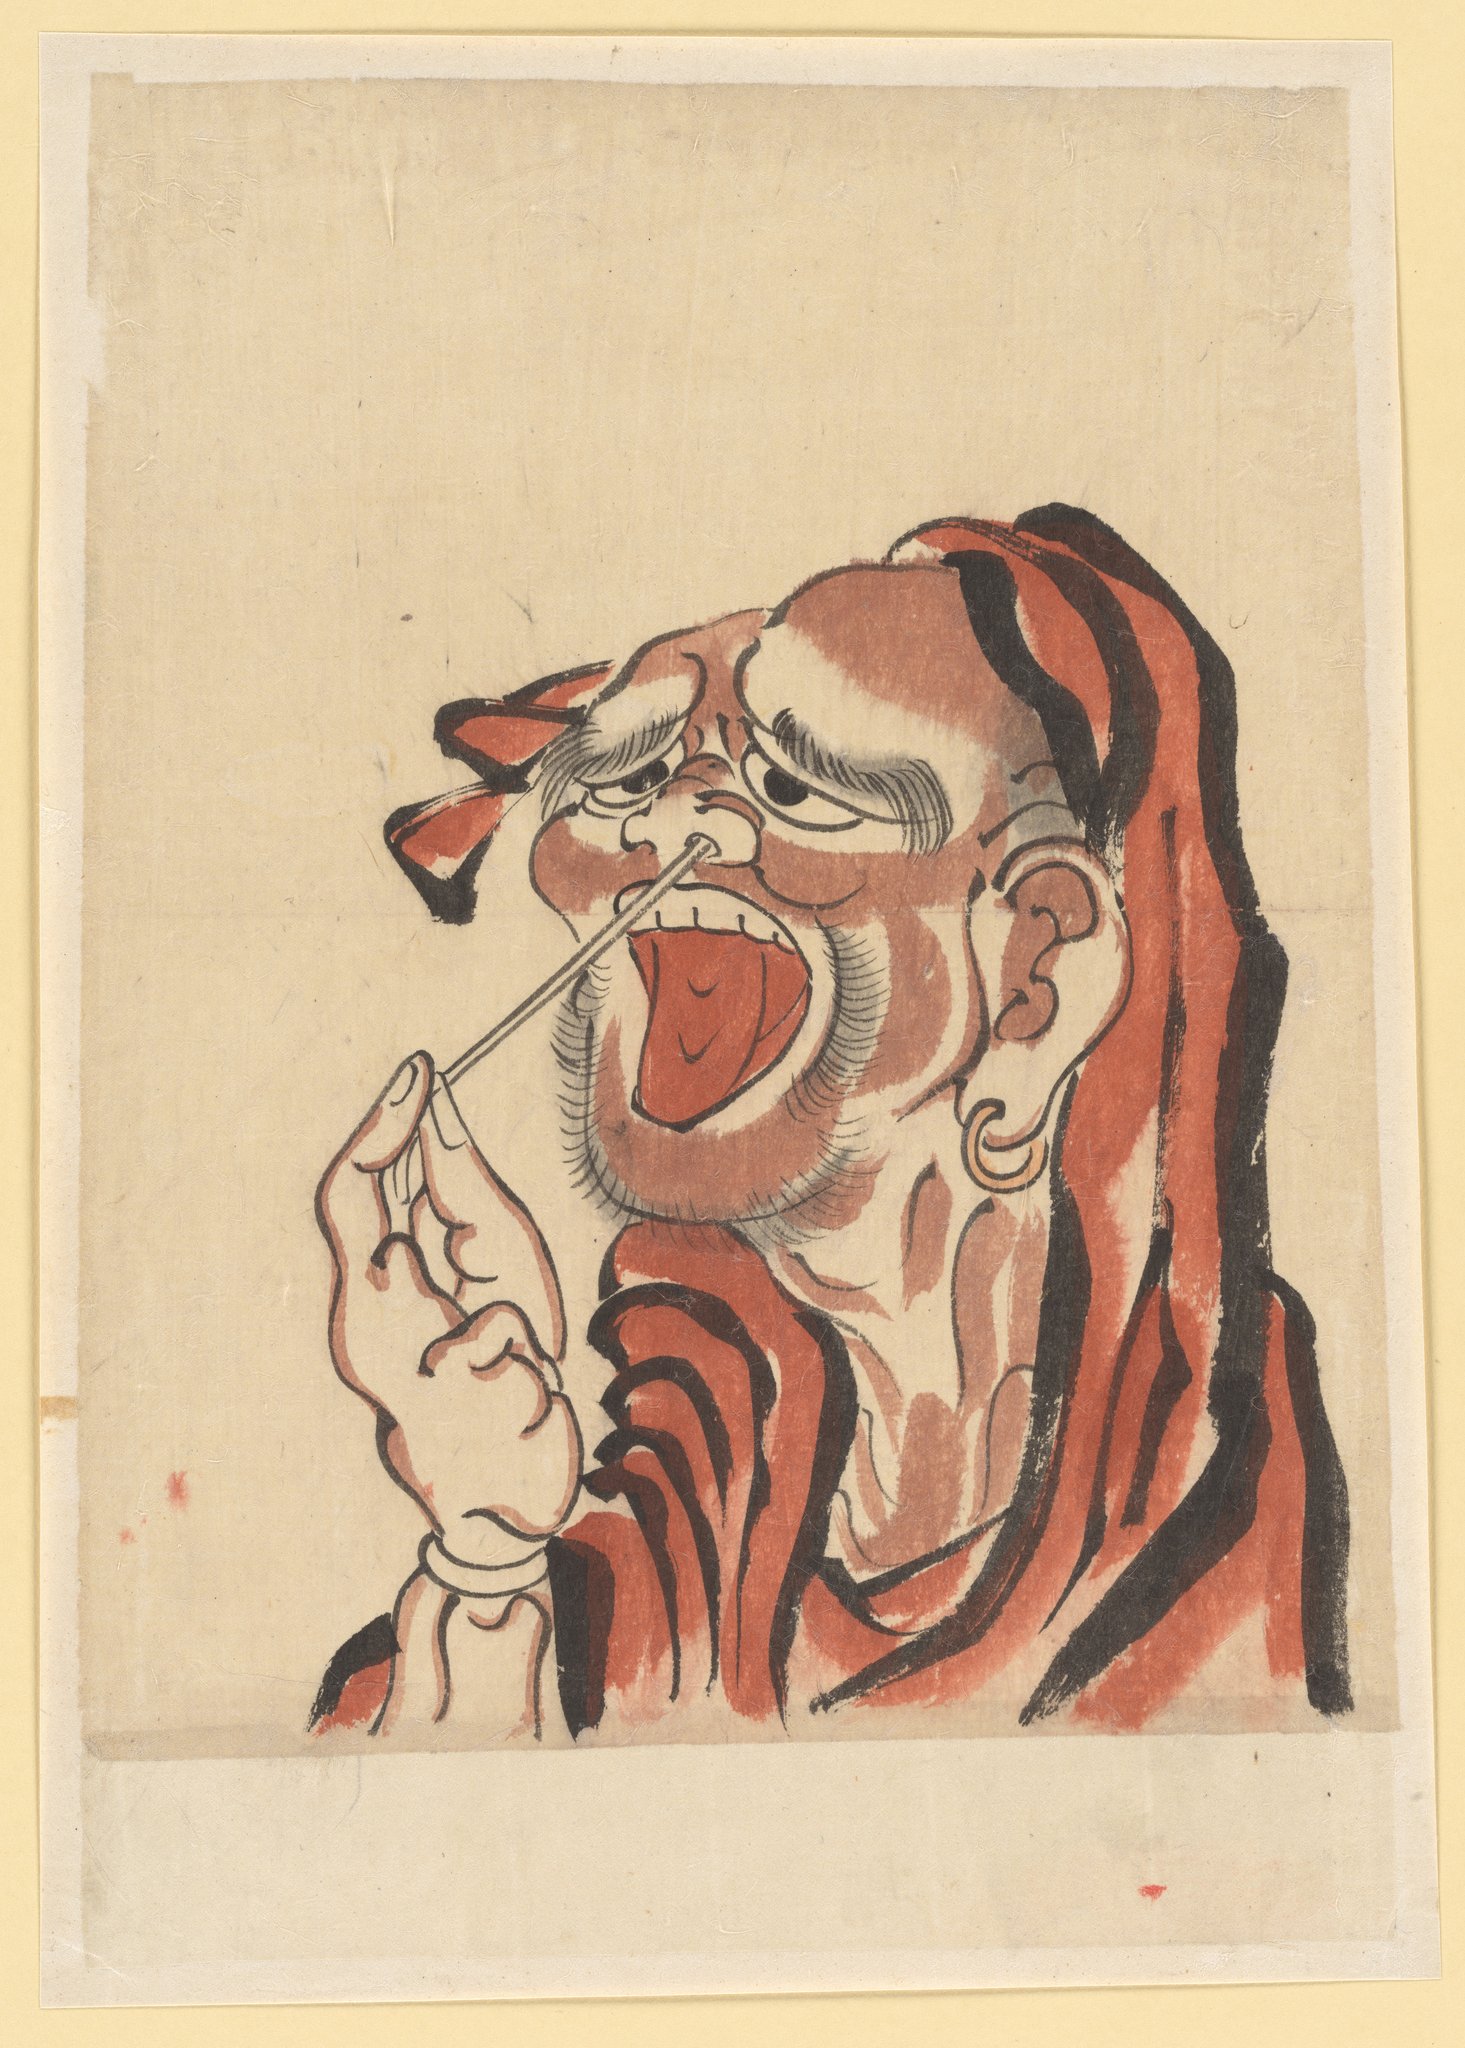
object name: drawing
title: Daruma (Buddhist Saint)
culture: japanese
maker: katsushika hokusai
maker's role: artist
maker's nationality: japanese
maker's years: 1760-1849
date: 1701-1900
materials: ink, paper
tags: buddhism,saints